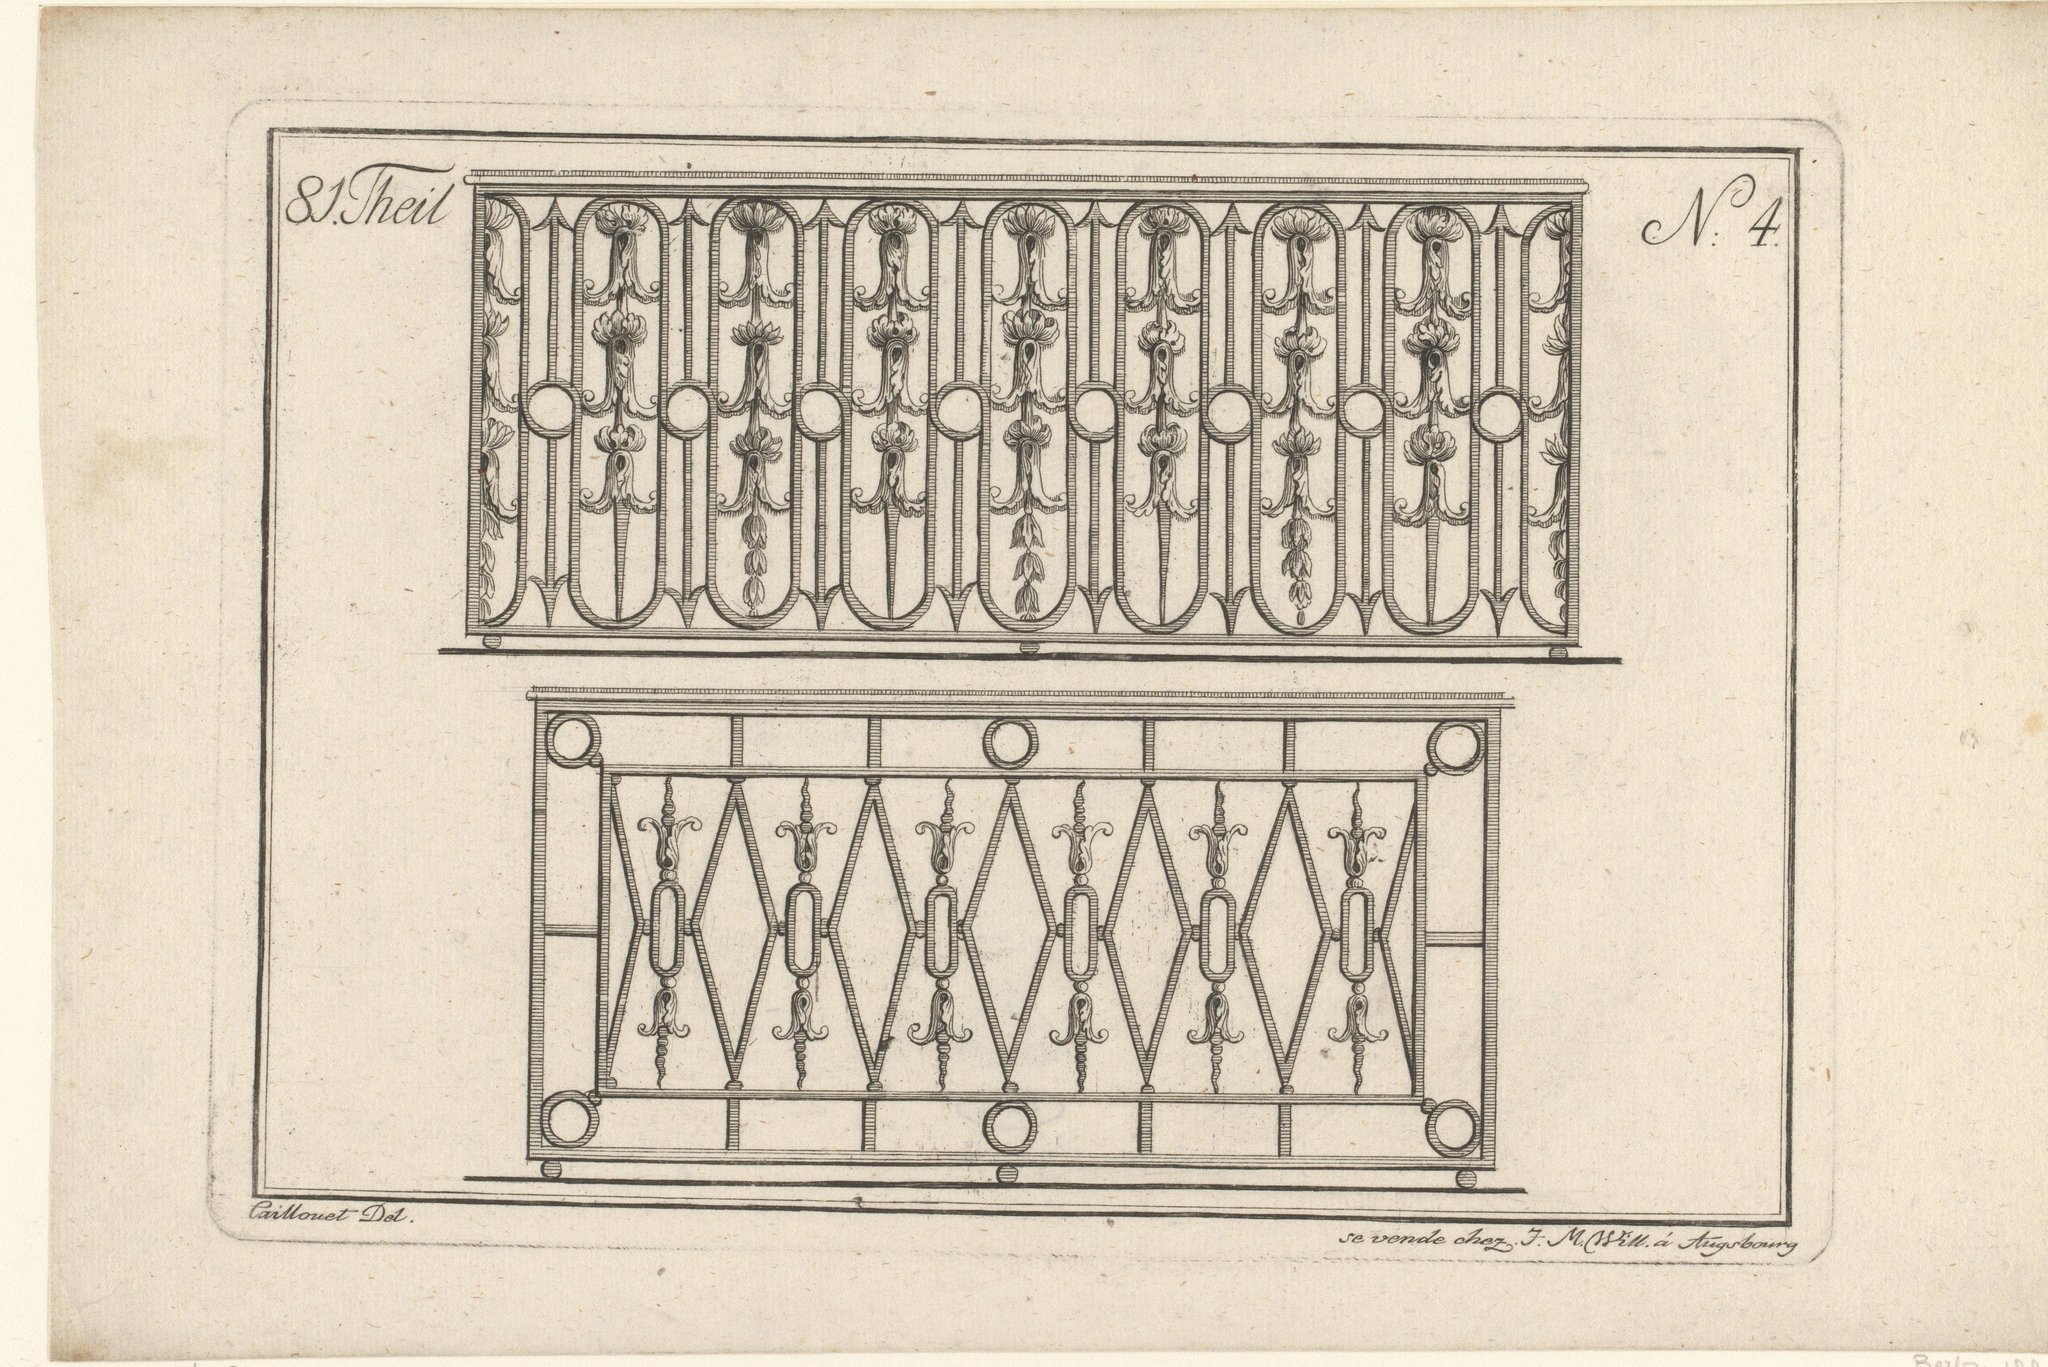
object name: print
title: 81. Theil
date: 1737-1806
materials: paper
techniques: etching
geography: augsburg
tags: welding (industrial process), fence, wall, paling, ornament derived from plant forms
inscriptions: collector's mark: Lugt 2228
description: Twee smeedijzeren hekwerken met blad- en bloemmotieven.